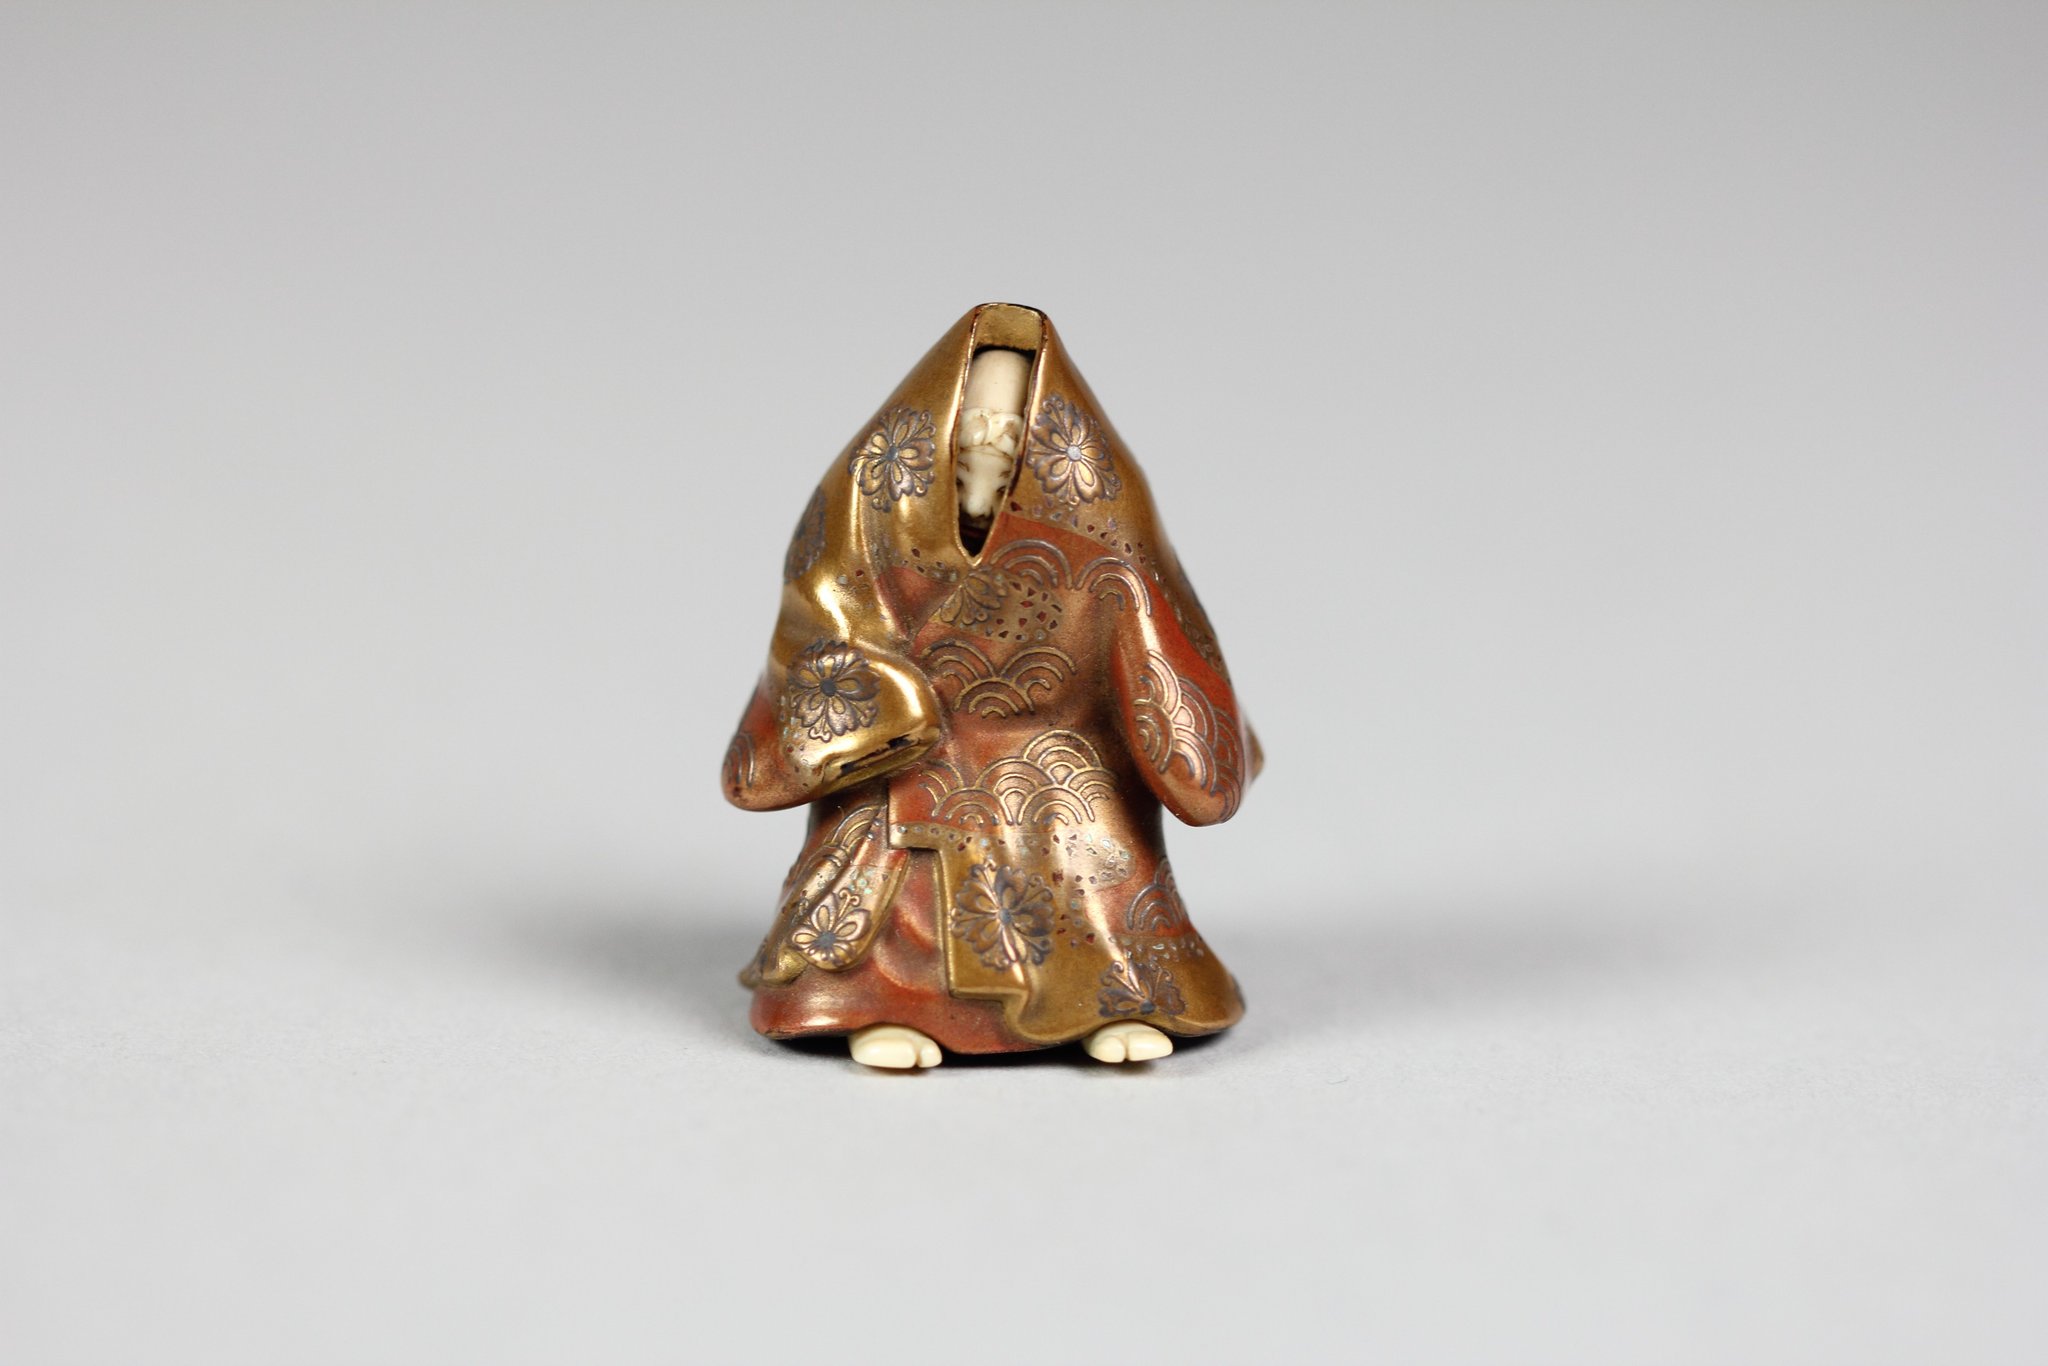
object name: netsuke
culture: japanese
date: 1801-1900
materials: ivory, wood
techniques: lacquer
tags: robes